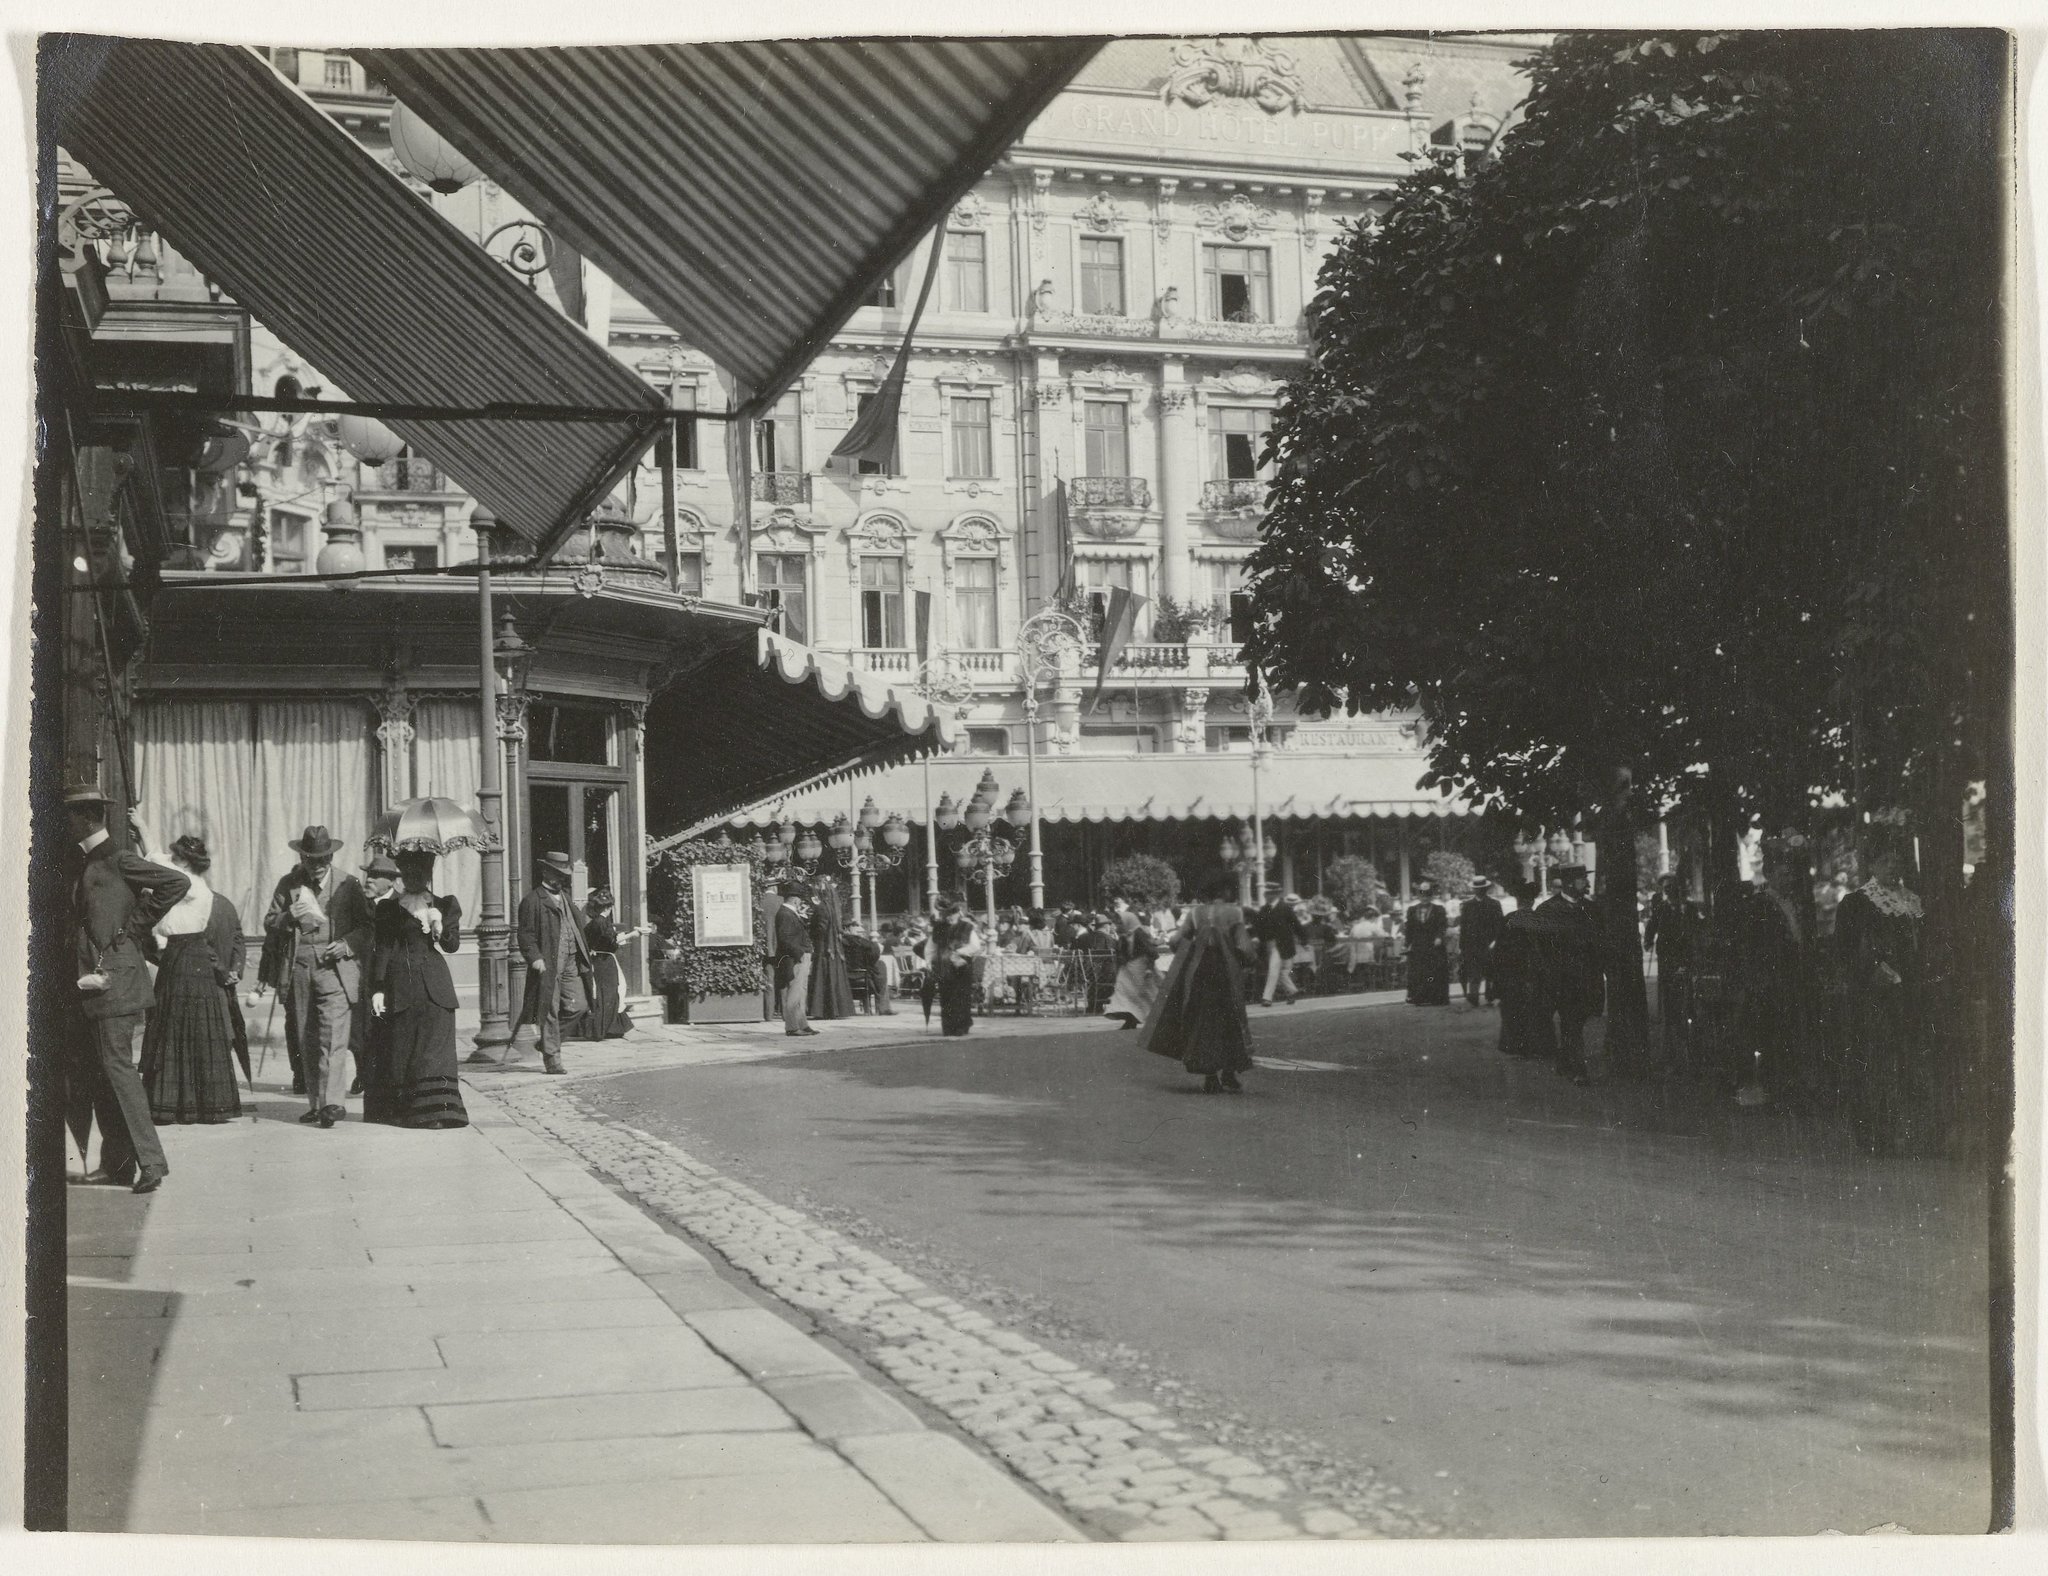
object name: photograph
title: Gezicht in een stad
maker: Anonymous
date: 1900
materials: paper, photographic support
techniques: gelatin silver print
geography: karlovy vary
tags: street (+ city(-scape) with figures, staffage)